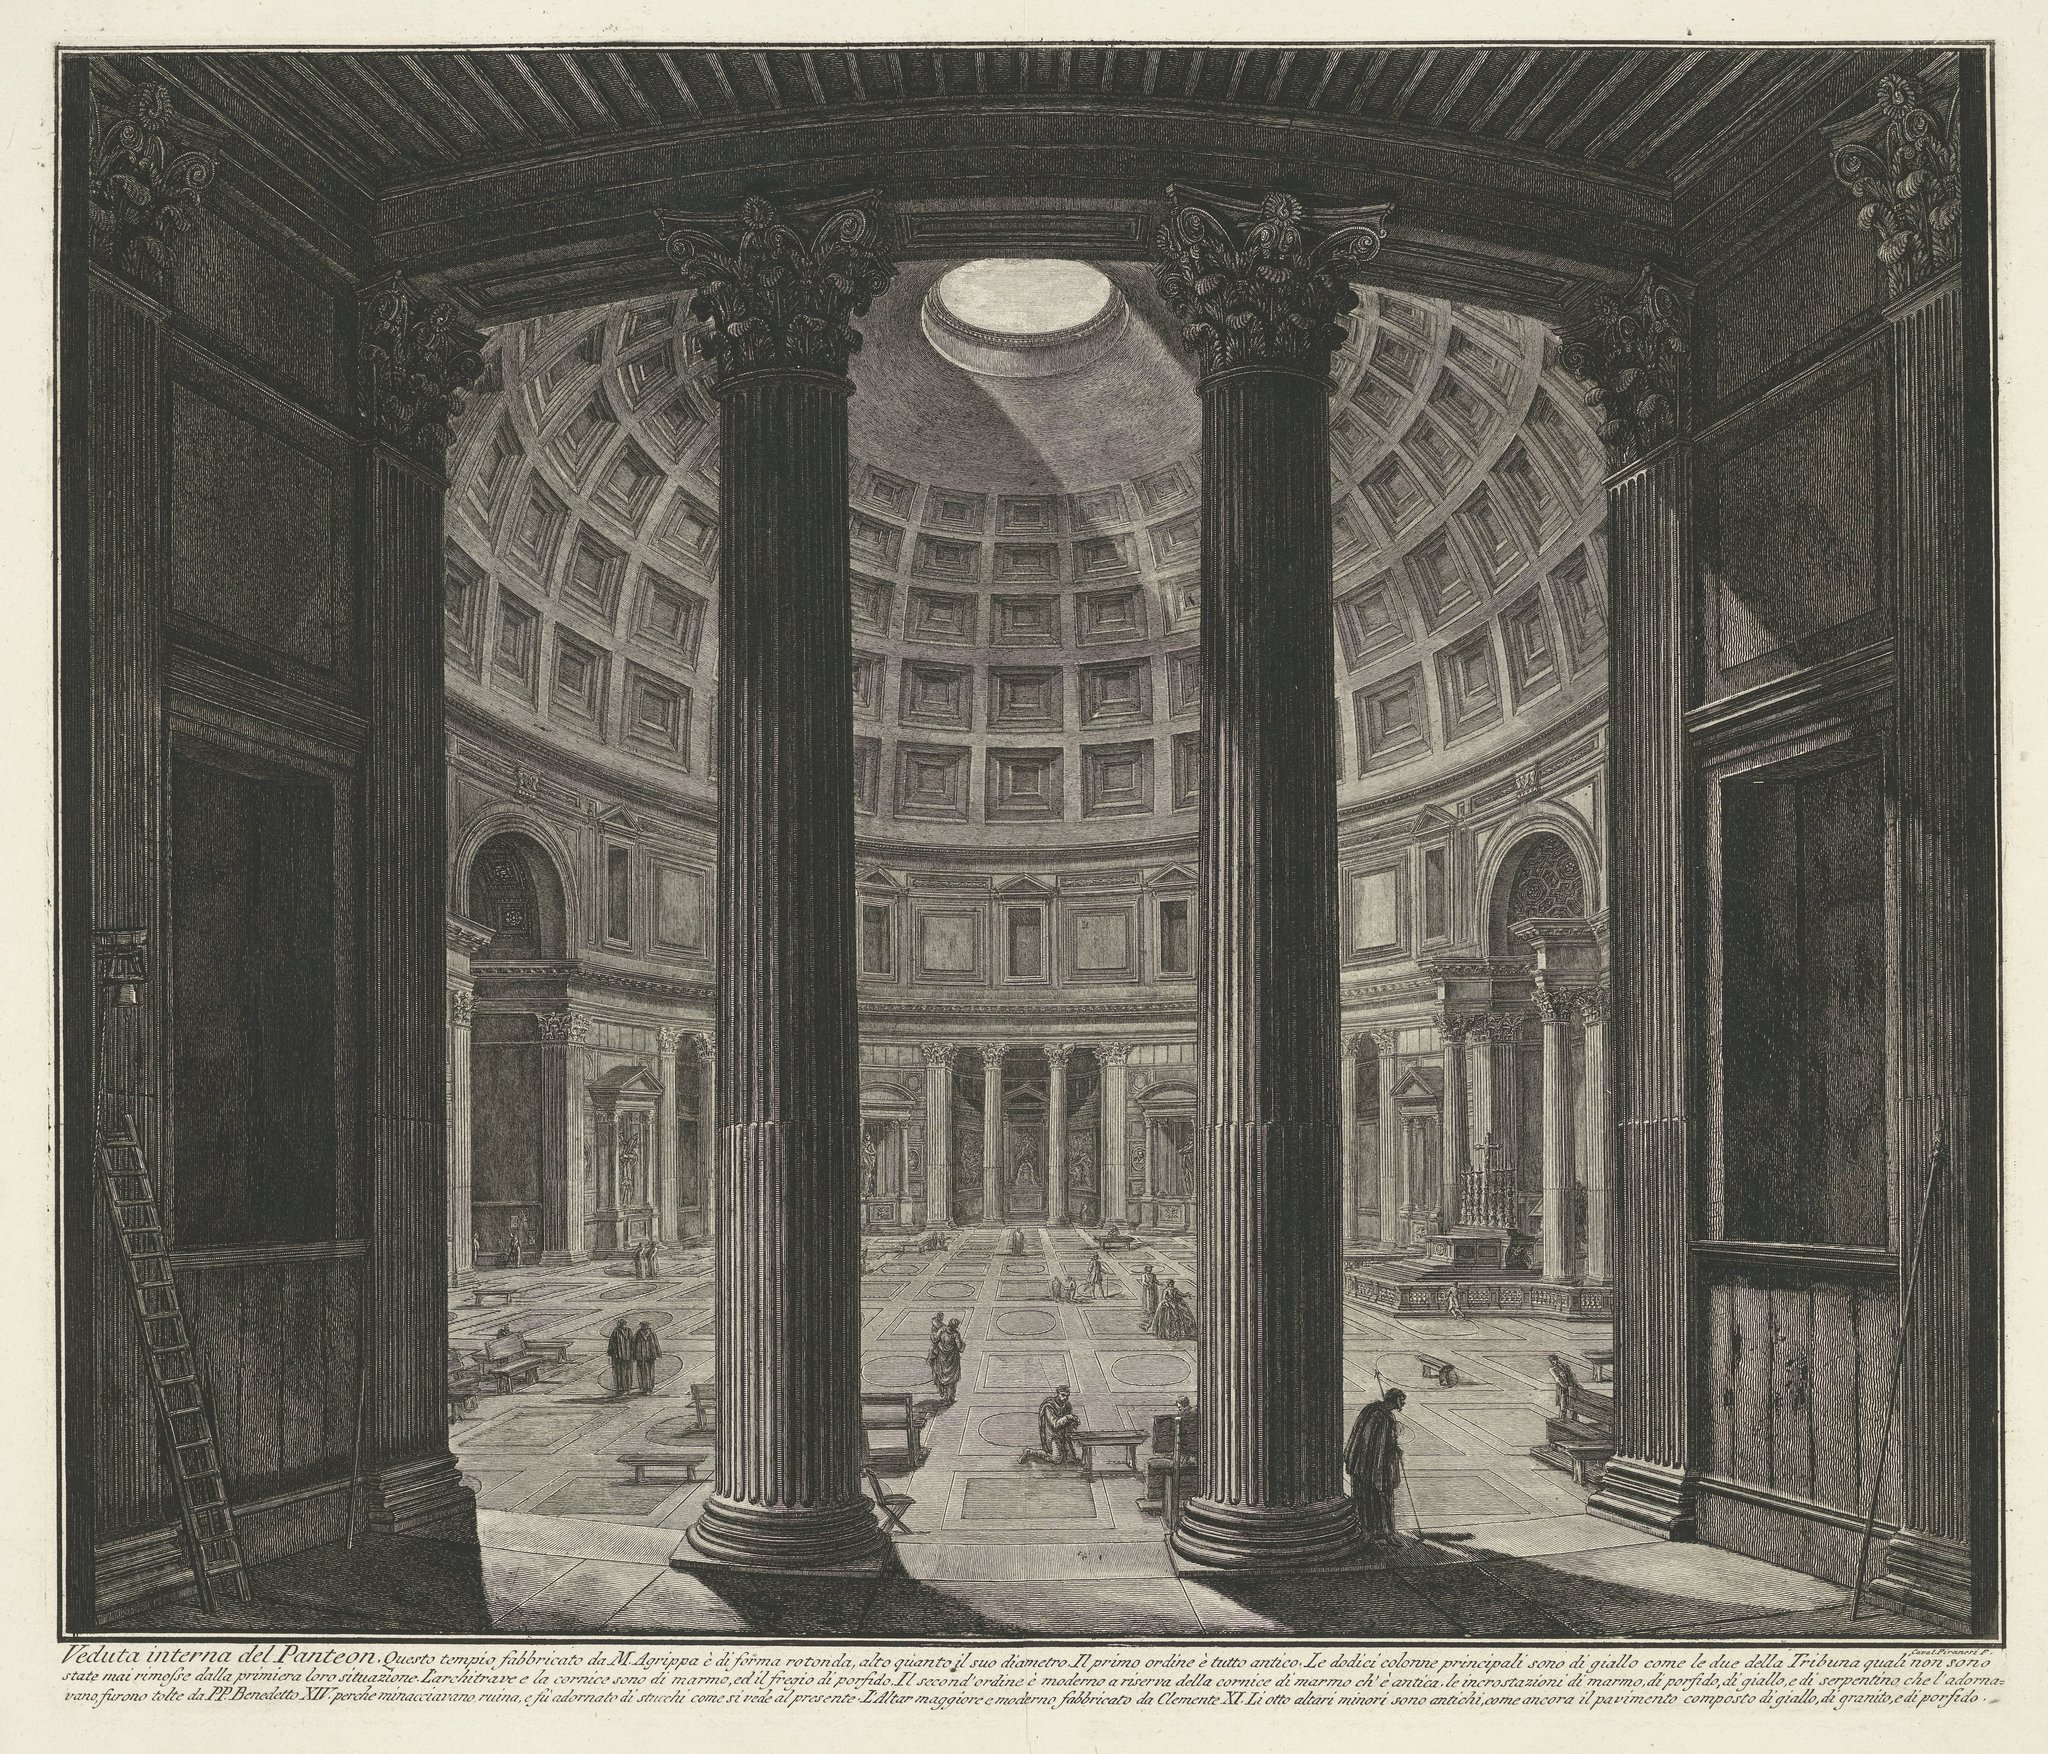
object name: print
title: Veduta interna del Panteon (...)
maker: giovanni battista piranesi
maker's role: designer, draughtsman, print maker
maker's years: 1720-1778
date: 1748-1778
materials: paper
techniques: etching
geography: rome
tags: roman catholic church, interior of church, temple, shrine ~ roman religion, rome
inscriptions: collector's mark: Lugt 2228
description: Deze prent maakt deel uit van de serie 'Vedute di Roma'. Piranesi werkte aan deze 135 platen tellende serie tussen 1748 en zijn dood in 1778. Francesco Piranesi voegde later nog twee prenten toe aan de reeks van zijn vader.